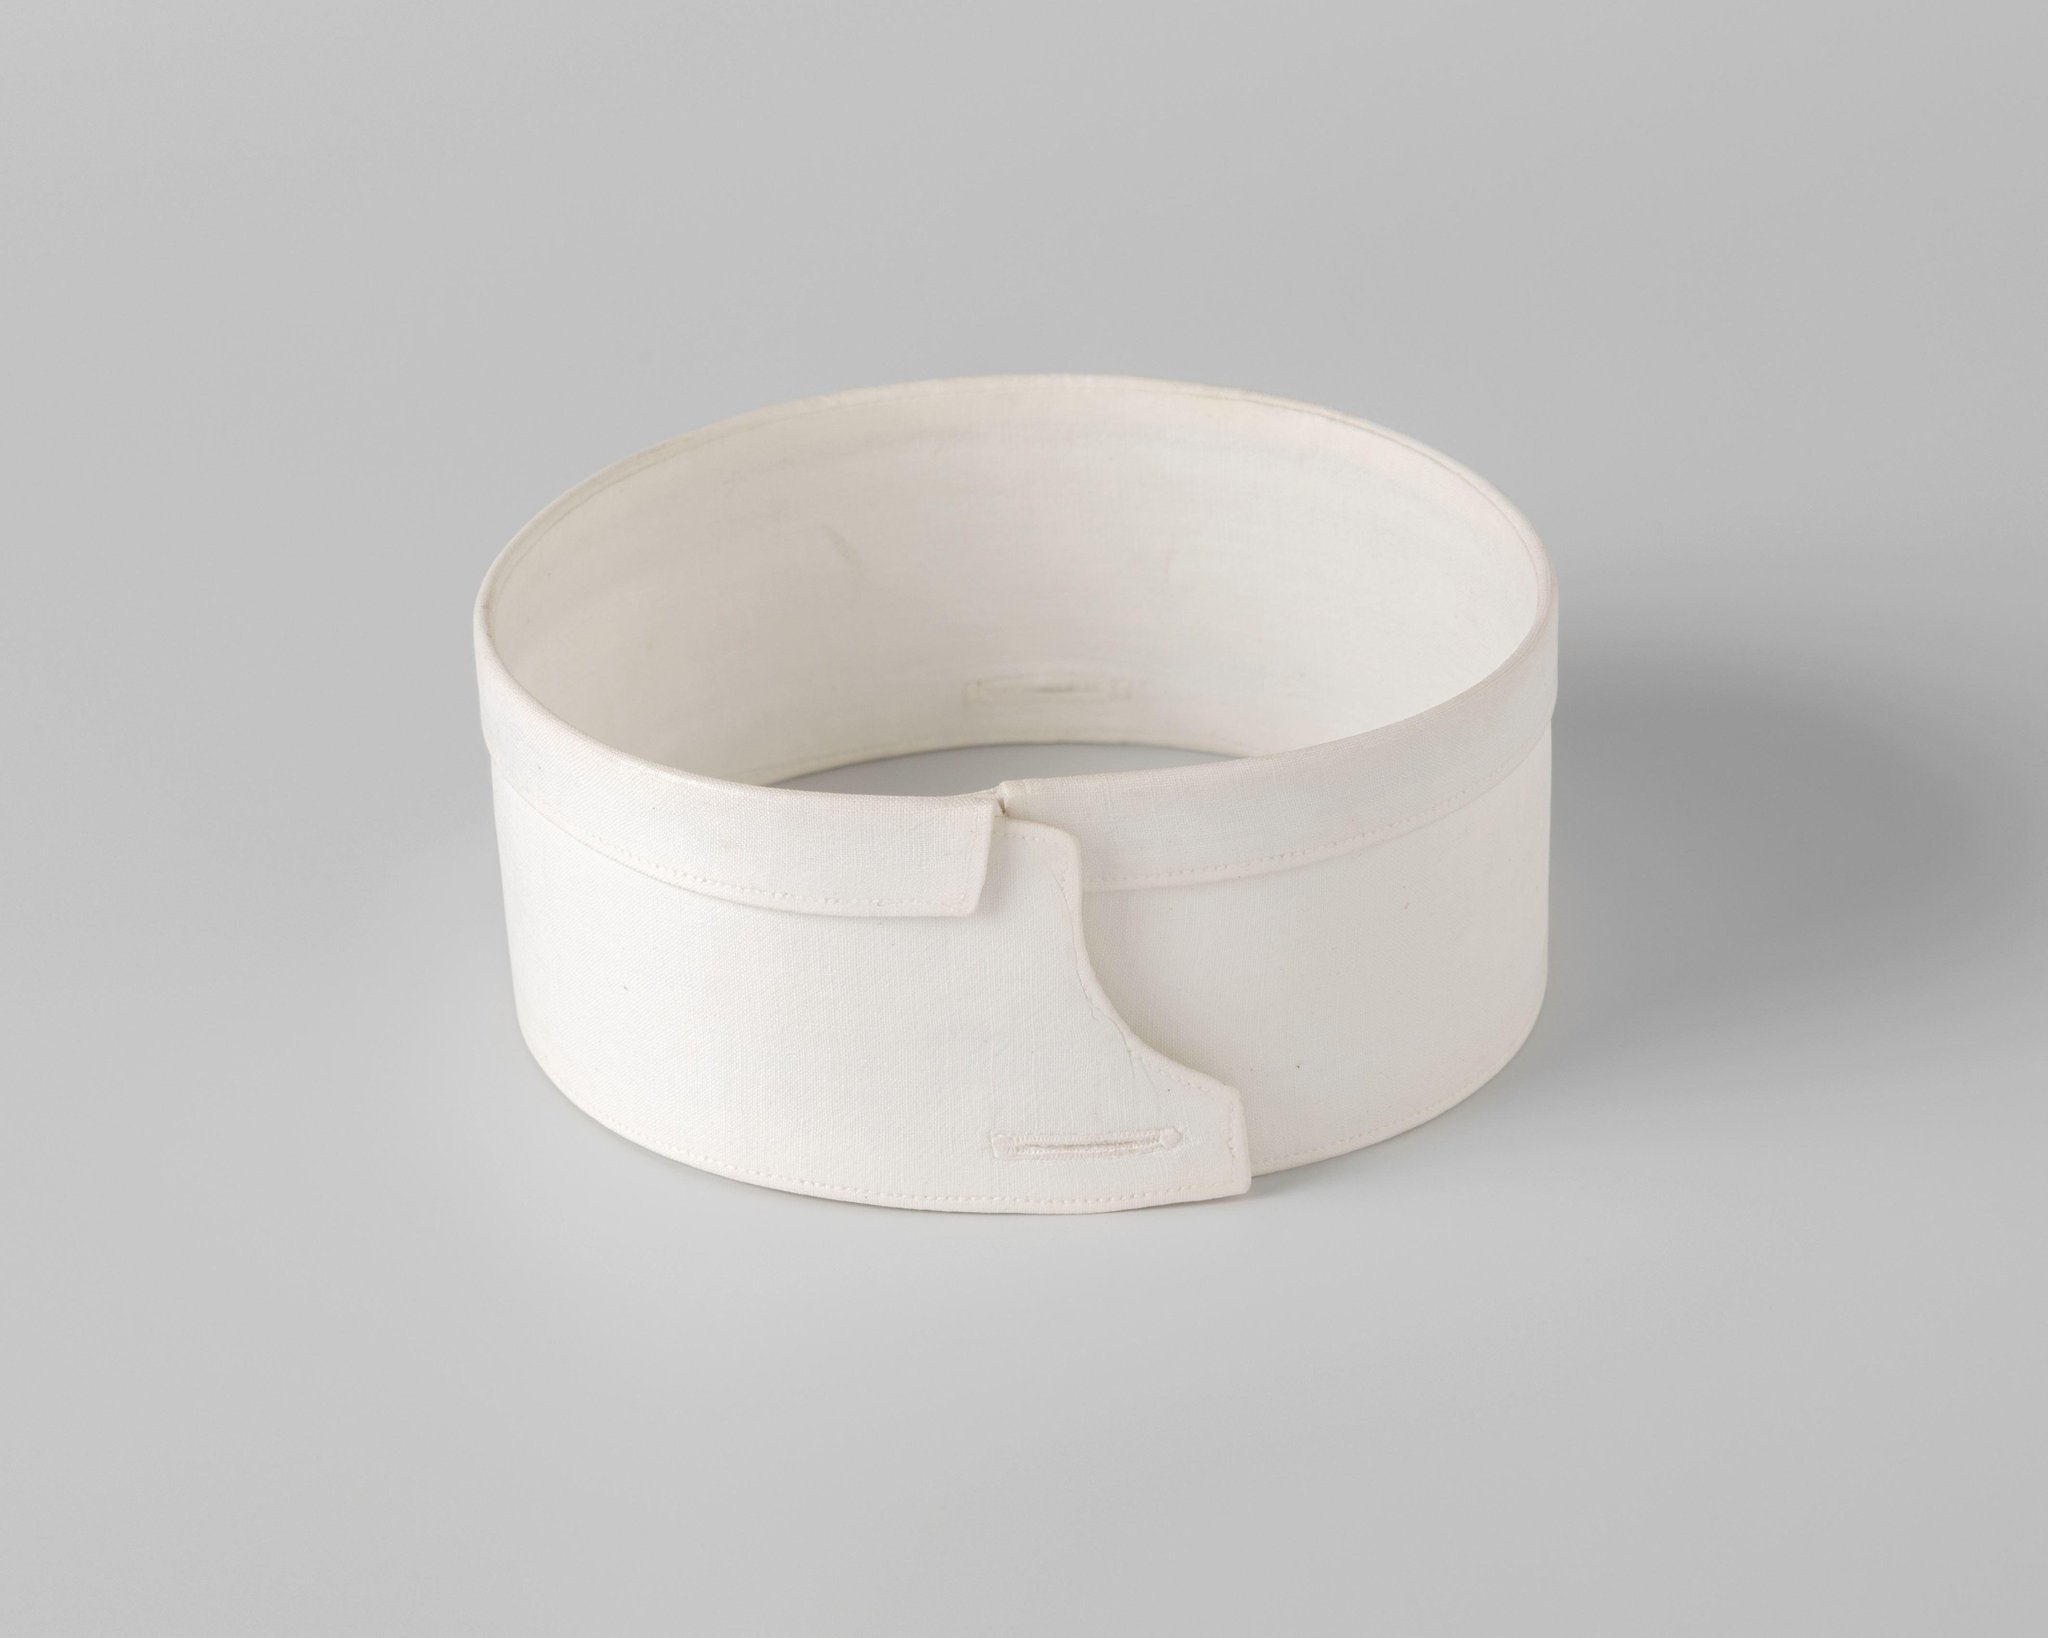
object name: womenswear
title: Boord van linnen, horend bij een amazonekostuum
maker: Anonymous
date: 1895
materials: linen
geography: france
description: Boord van linnen, horend bij een amazonekostuum. Met omslag en het merk (?) TOILE MARGUERITE 35. Bewaard in een met turquoise moiré-papier beplakte doos met adres MARGUERITE 35.